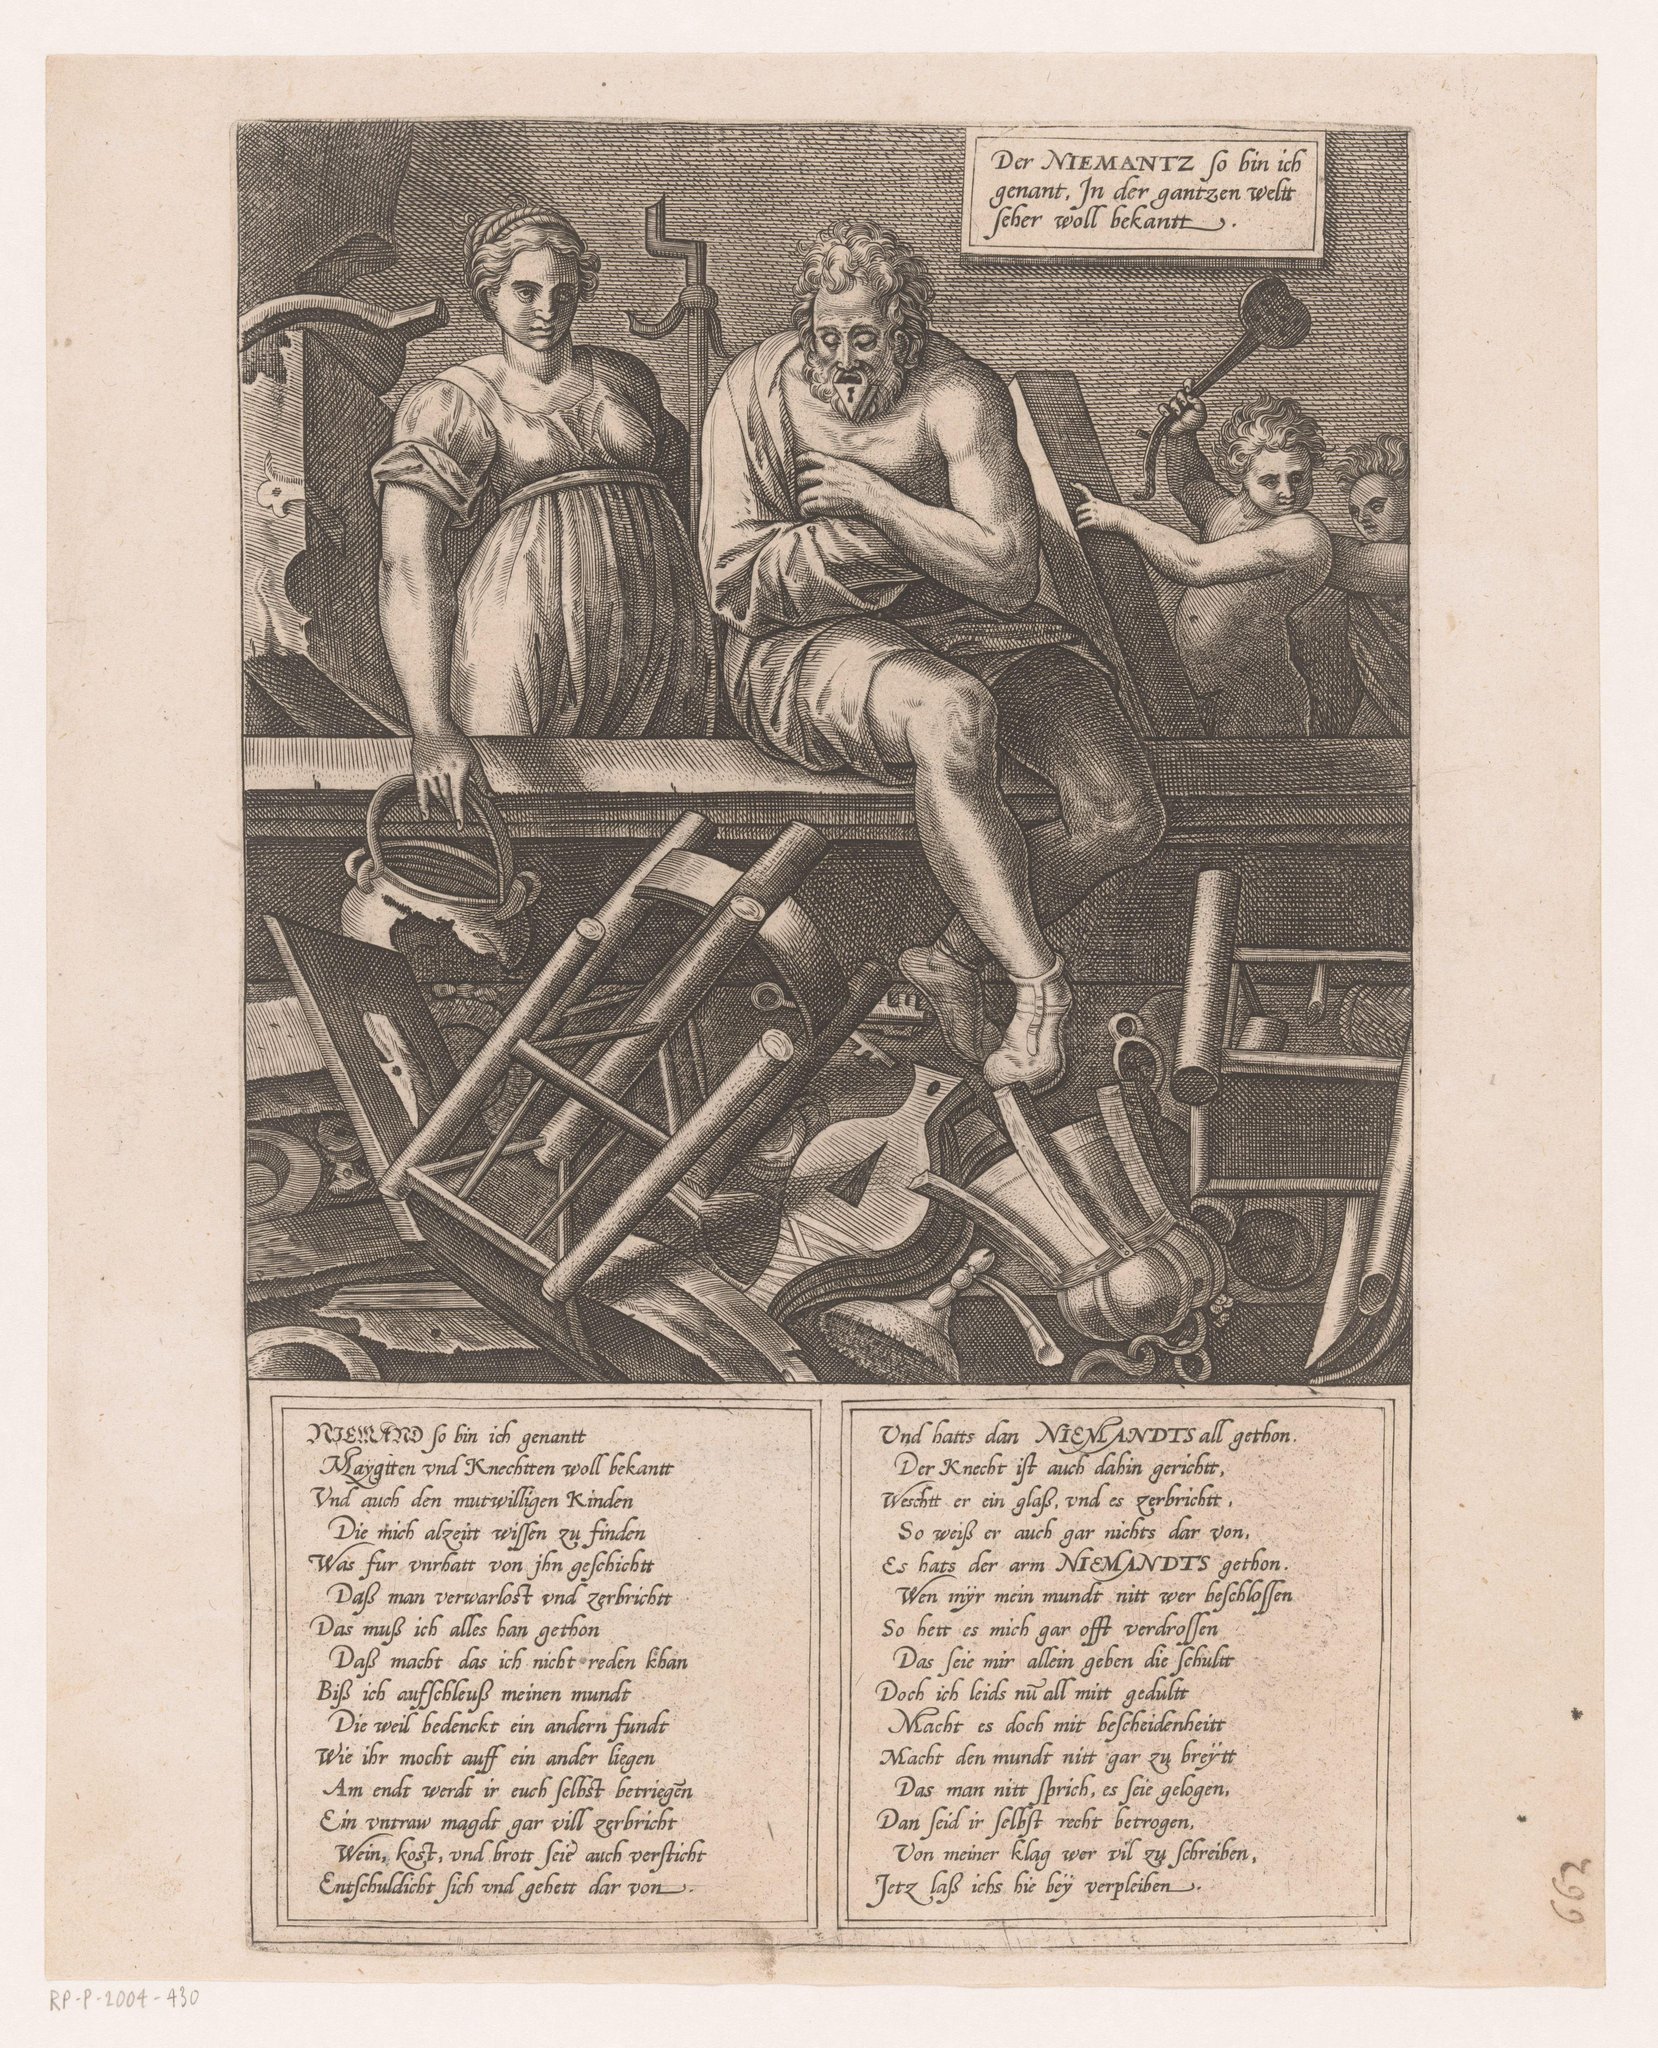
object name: print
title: Personificatie van Niemand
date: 1833-1886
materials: paper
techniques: engraving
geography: germany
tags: nobody, 'nemo'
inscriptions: collector's mark: Lugt 2760, collector's mark: Lugt 2228